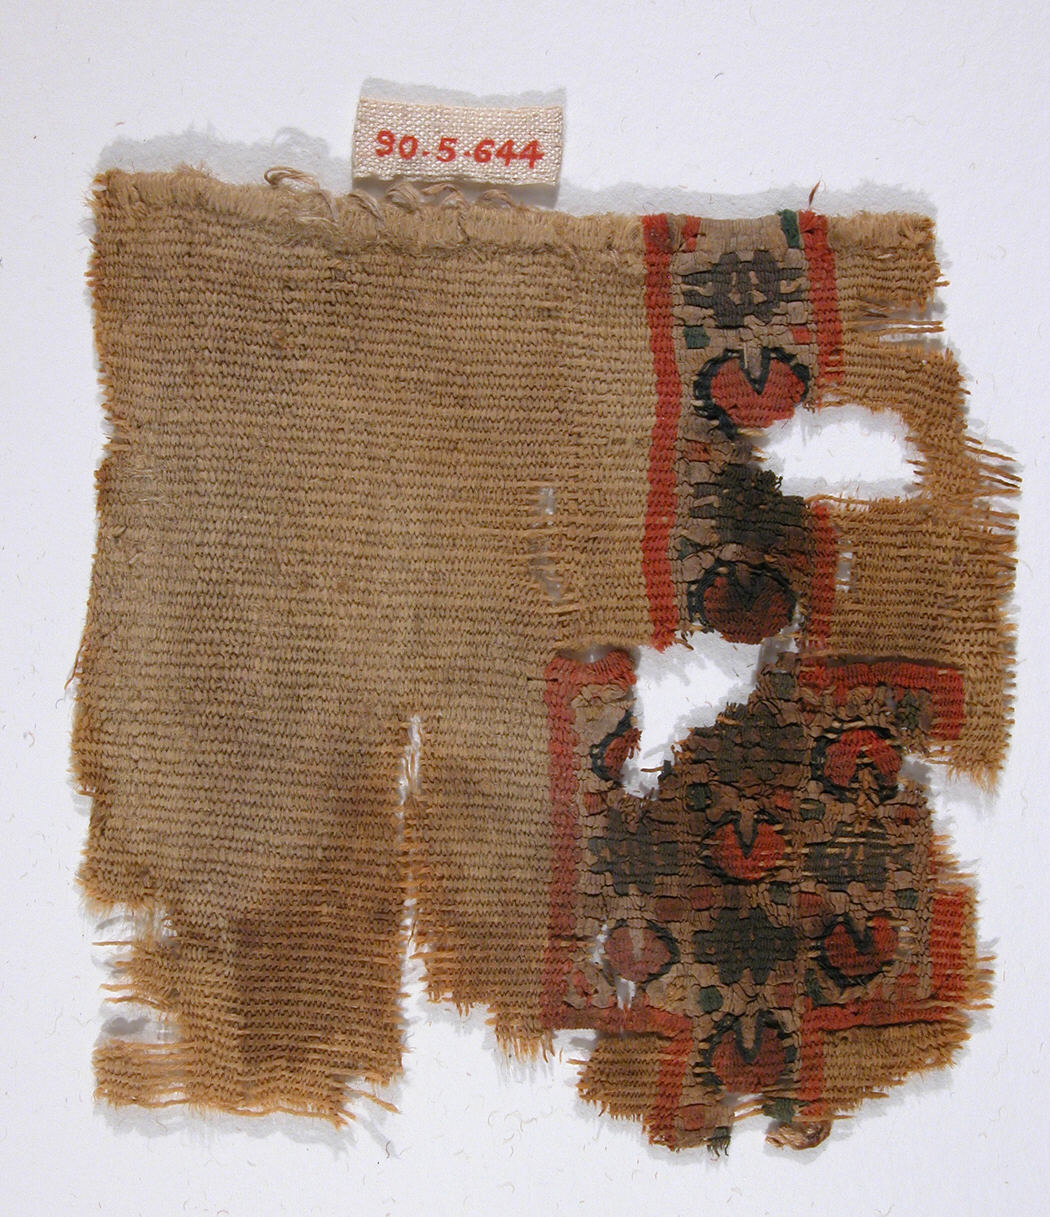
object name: textile fragment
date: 401-600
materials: linen, wool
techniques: weave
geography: egypt